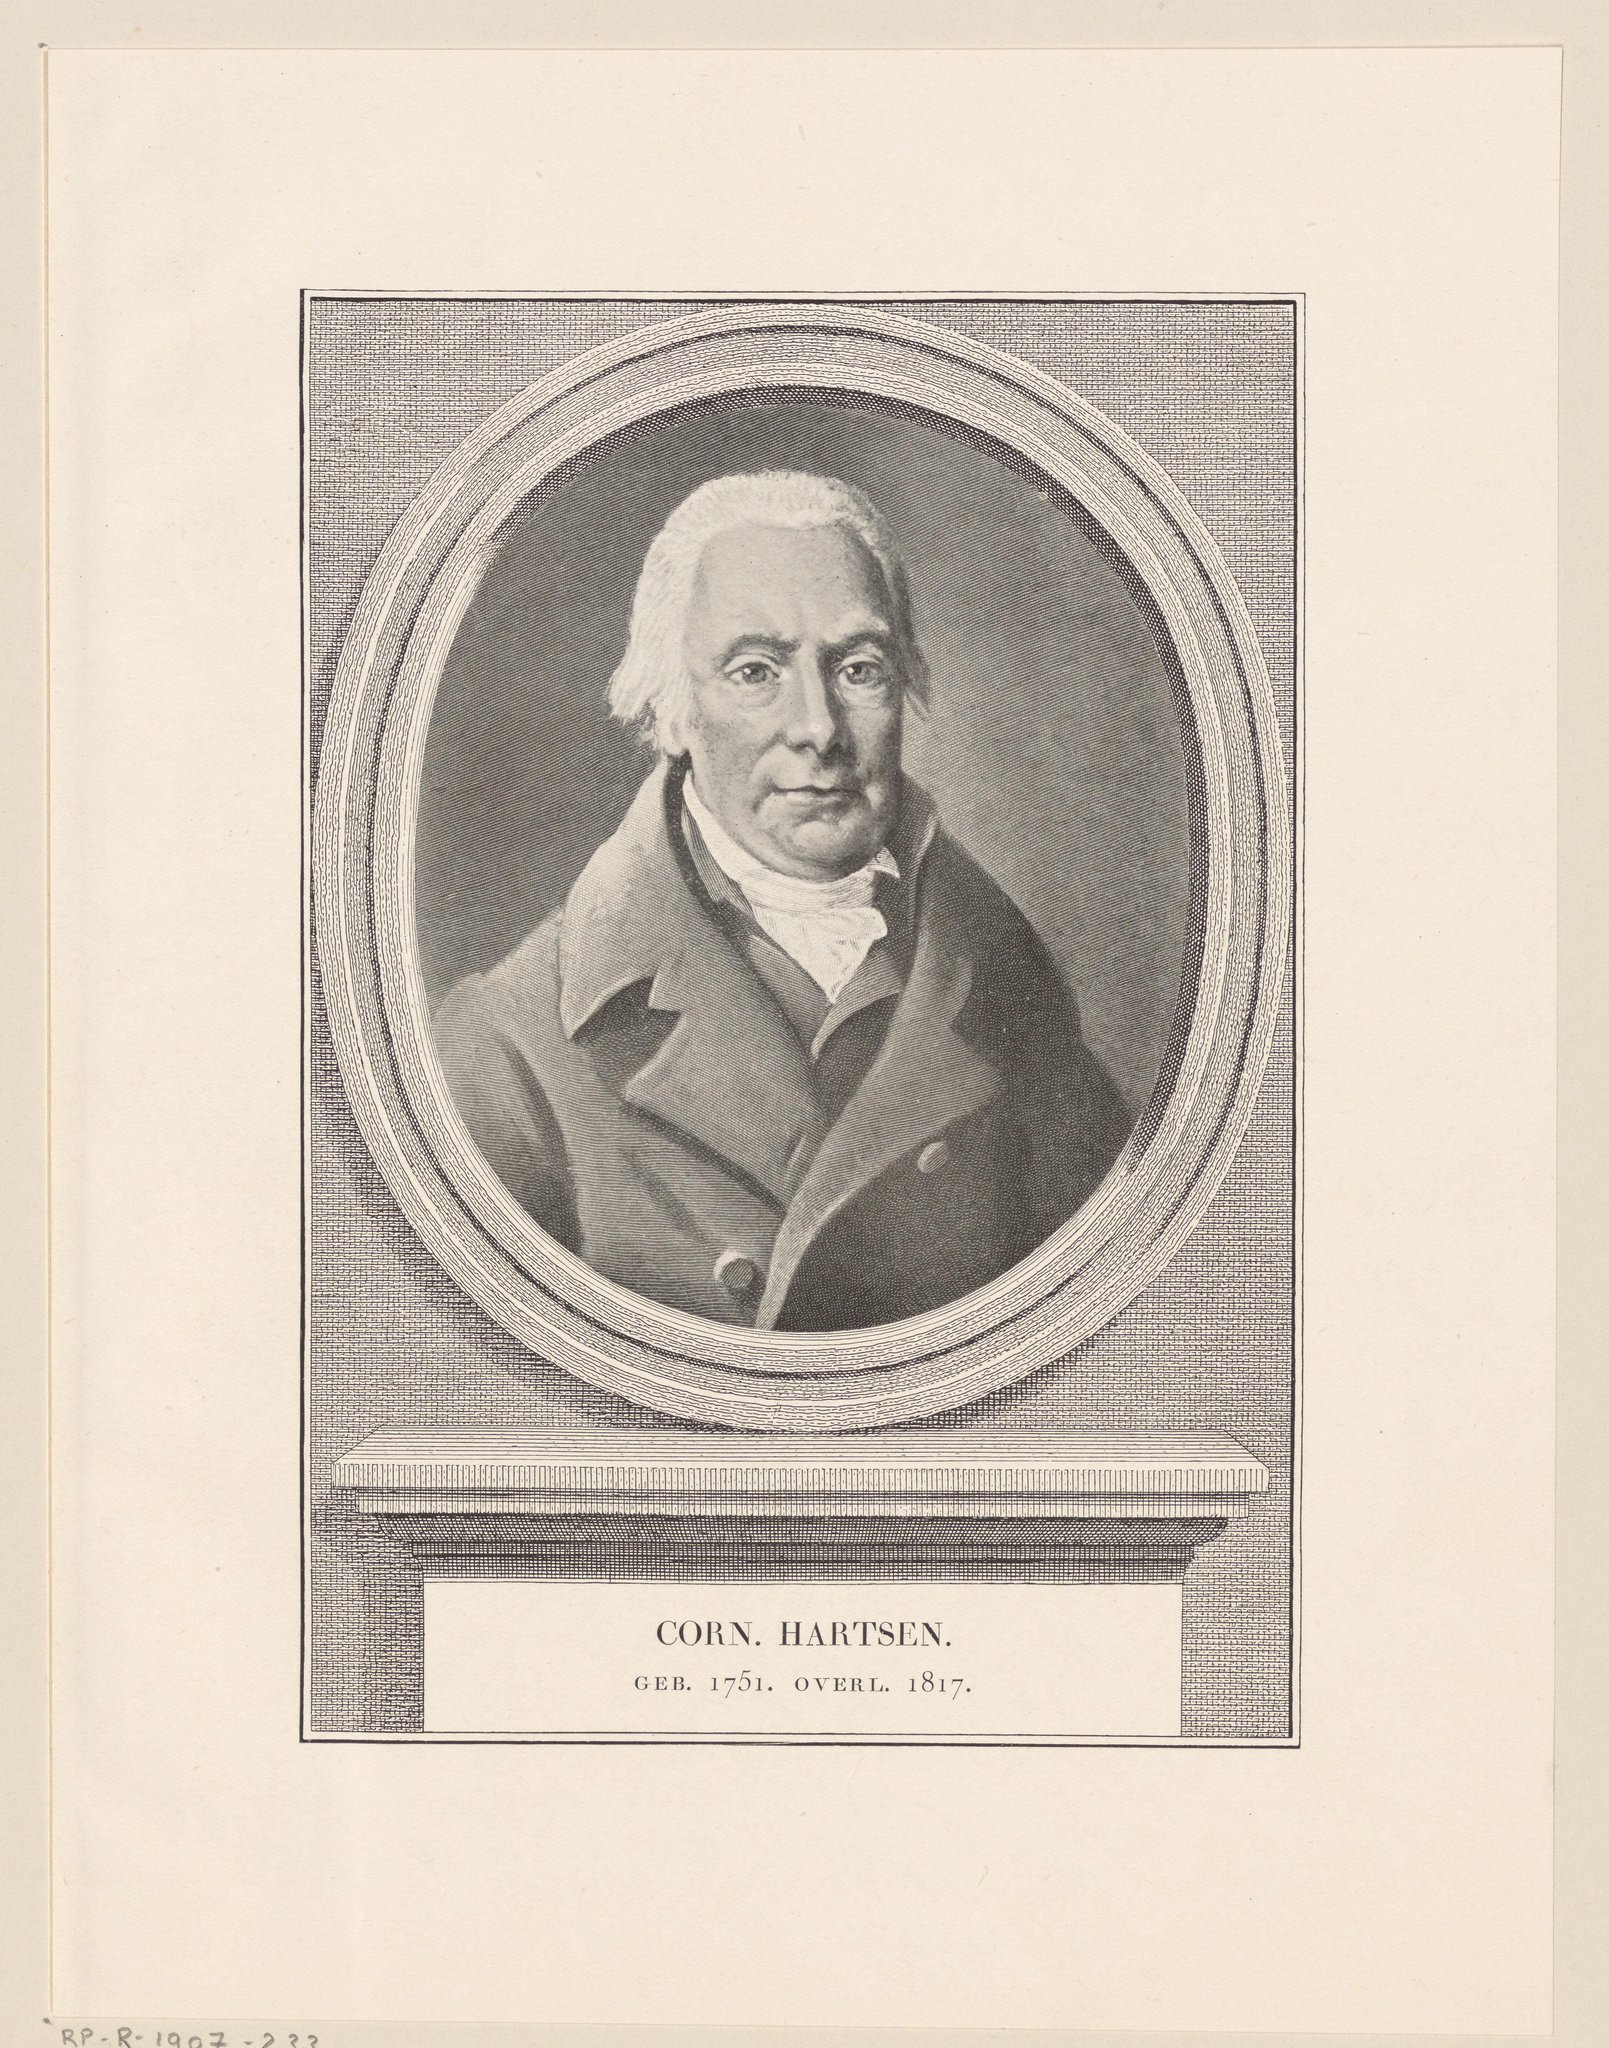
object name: photomechanical print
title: Portret van Cornelis Hartsen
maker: Anonymous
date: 1900-1907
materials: paper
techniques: autotype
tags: historical persons, merchant, salesman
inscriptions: collector's mark: Lugt 2228